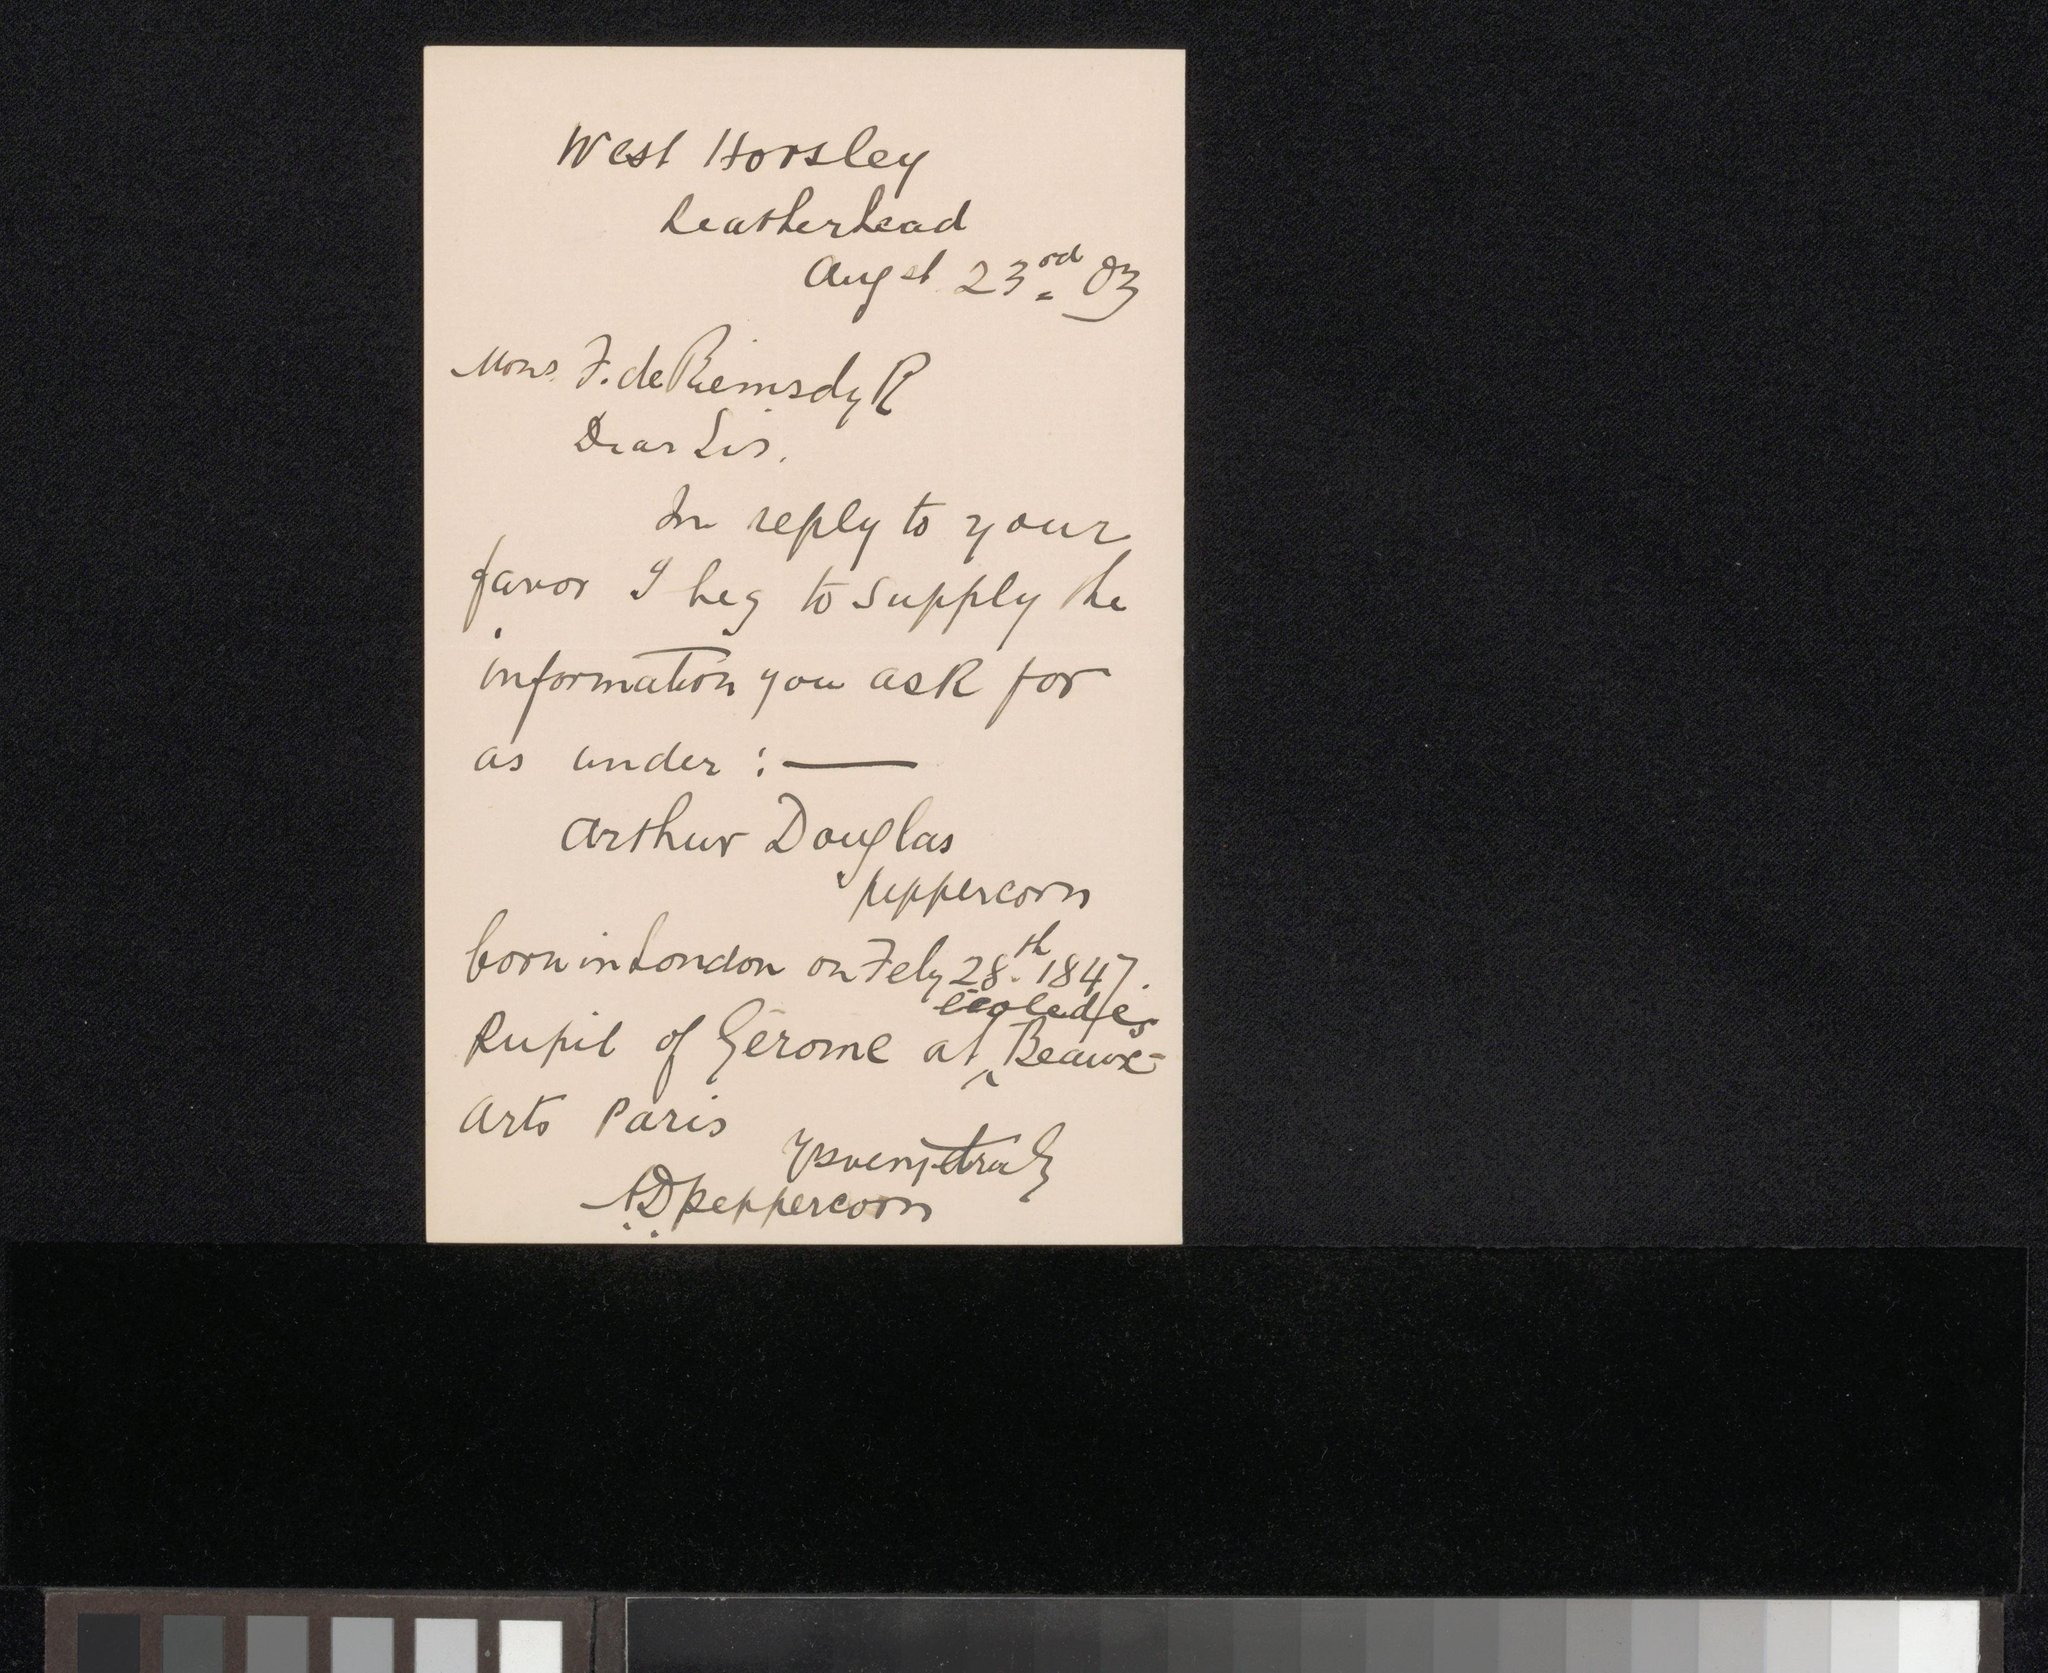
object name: letter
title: Brief aan jonkheer Theodorus Helenus Franciscus van Riemsdijk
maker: arthur douglas peppercorn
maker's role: painter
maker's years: 1847-1926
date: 1903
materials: ink, paper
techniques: pen, writing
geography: leatherhead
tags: print maker, sculptor, jean-léon gérôme, maastricht, london, paris